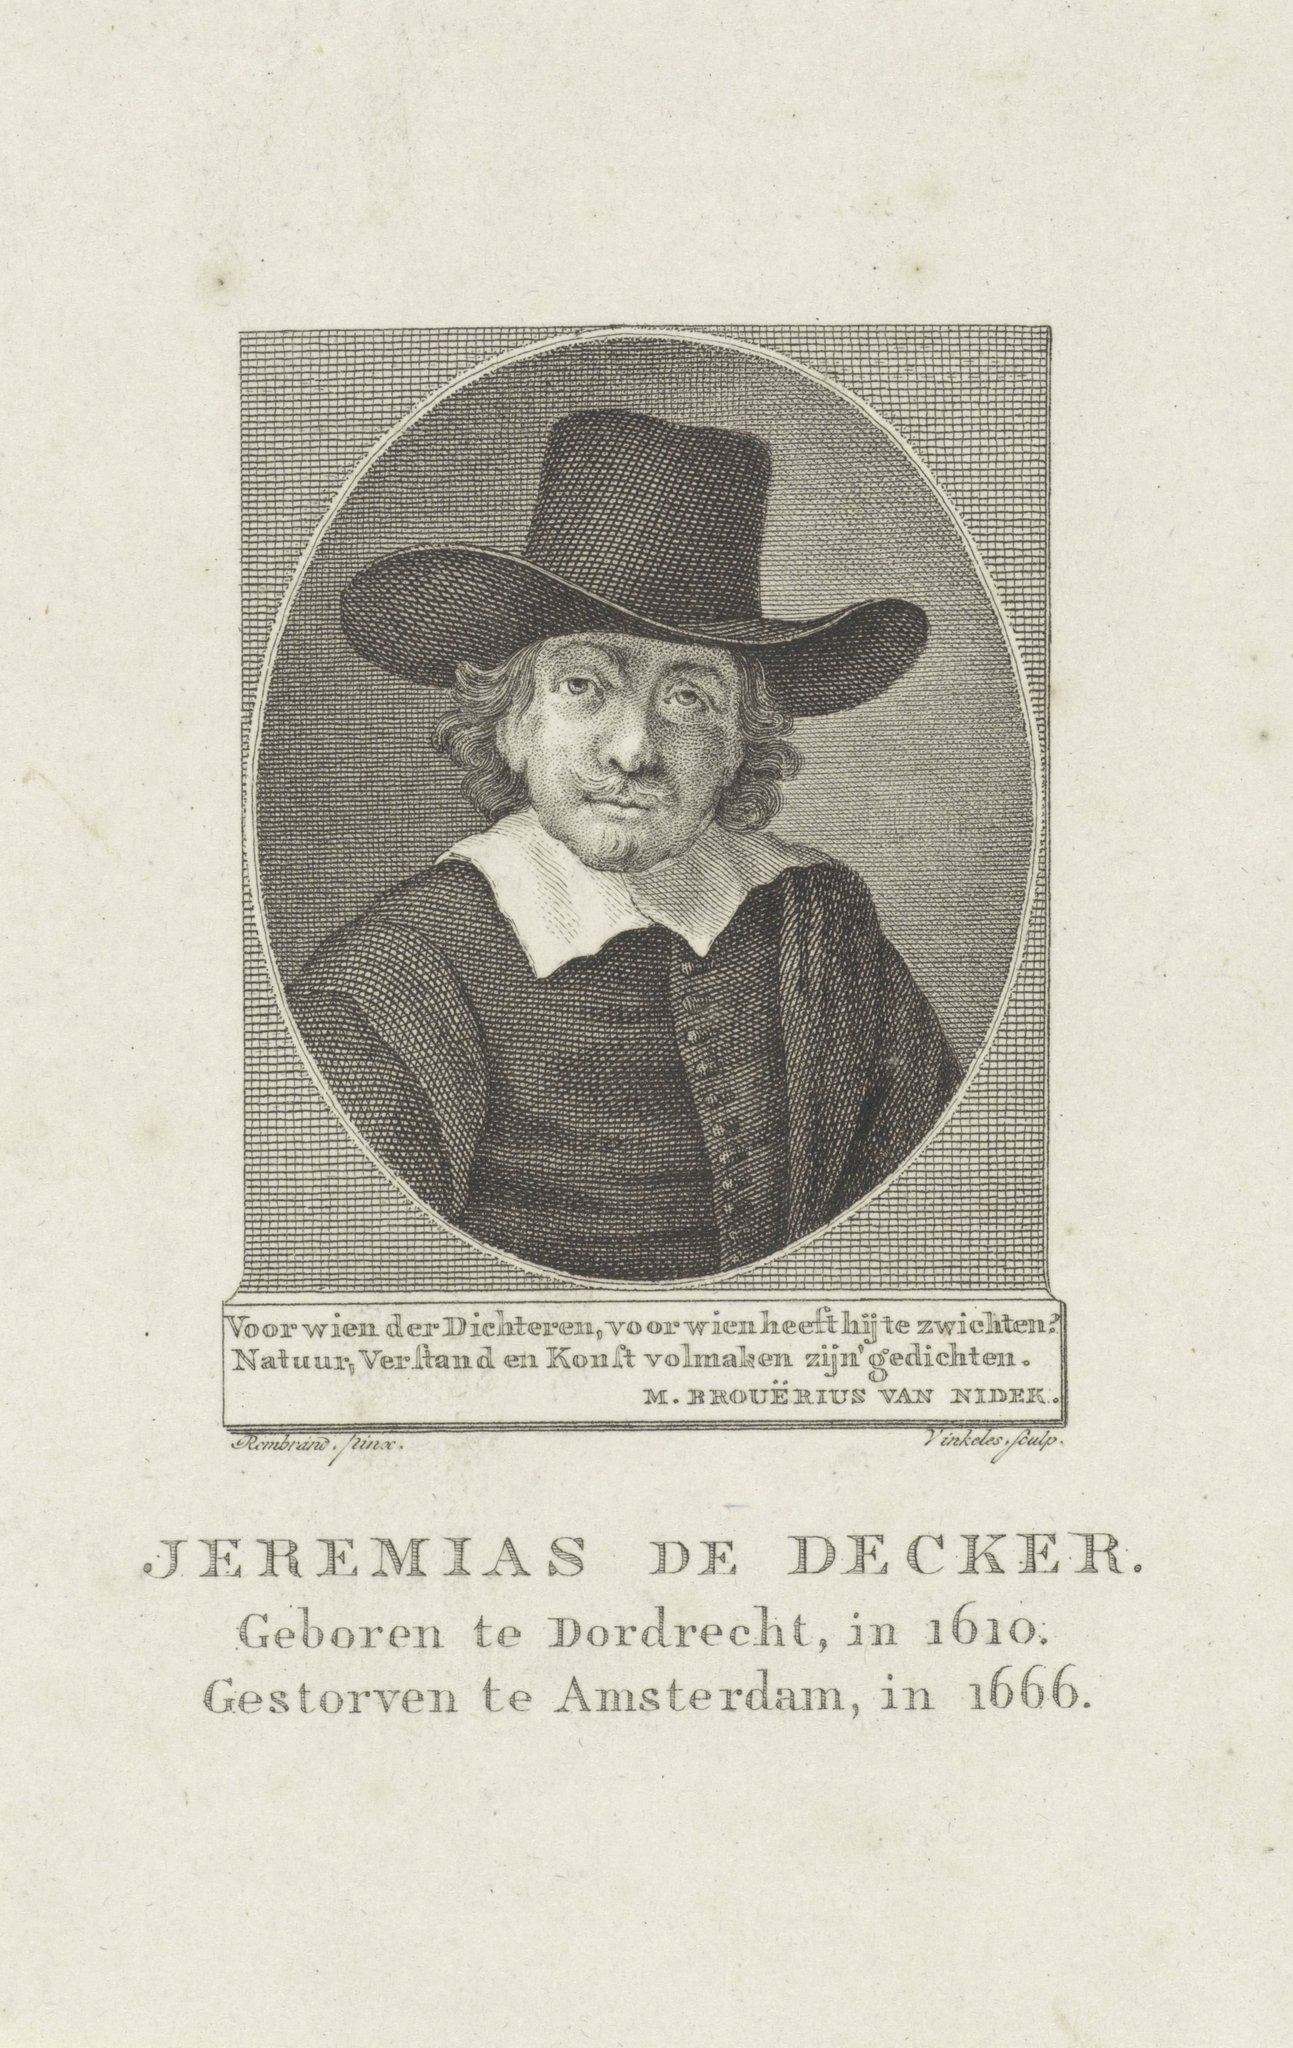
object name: print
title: Portret van Jeremias de Decker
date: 1807-1816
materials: paper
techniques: etching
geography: amsterdam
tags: dordrecht, amsterdam, jeremias de decker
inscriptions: collector's mark: Lugt 2228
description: Prent gebruikt als titelpagina voor: Vries, J. de. Jeremias de Dekker. Amsterdam: weduwe Gerrit Warnars en Petrus den Hengst, 1807.